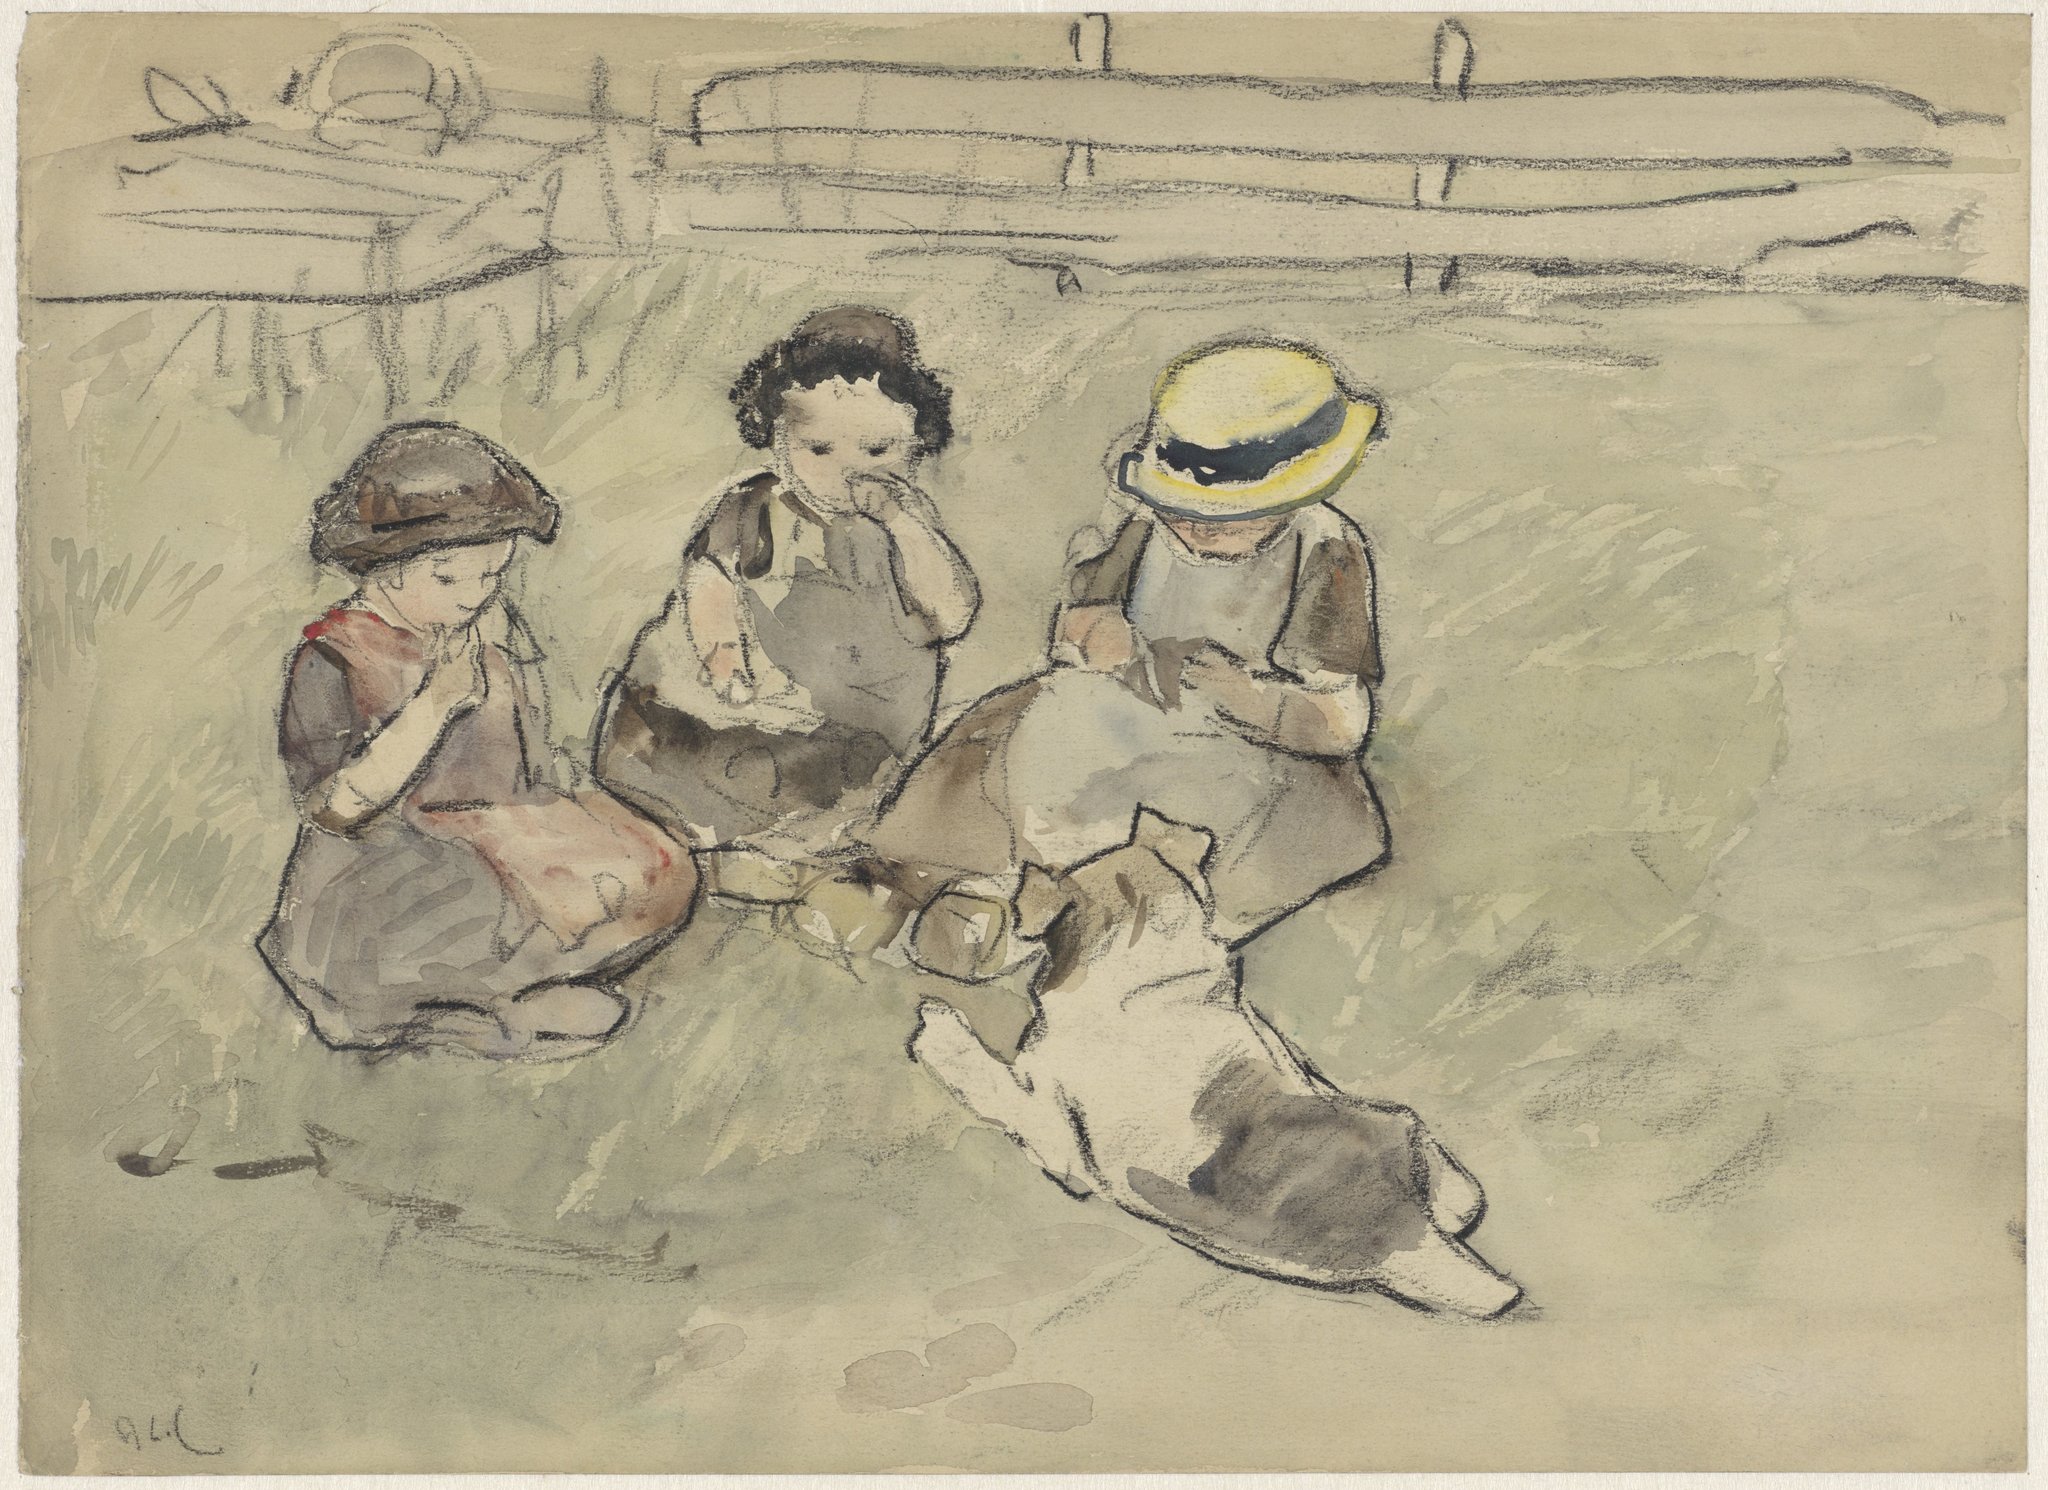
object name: watercolor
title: Drie meisjes met een hond zittend in een weiland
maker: adolf le comte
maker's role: draughtsman, painter, print maker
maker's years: 1850-1921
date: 1860-1921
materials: chalk, paper, watercolor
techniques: brush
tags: children's games and plays